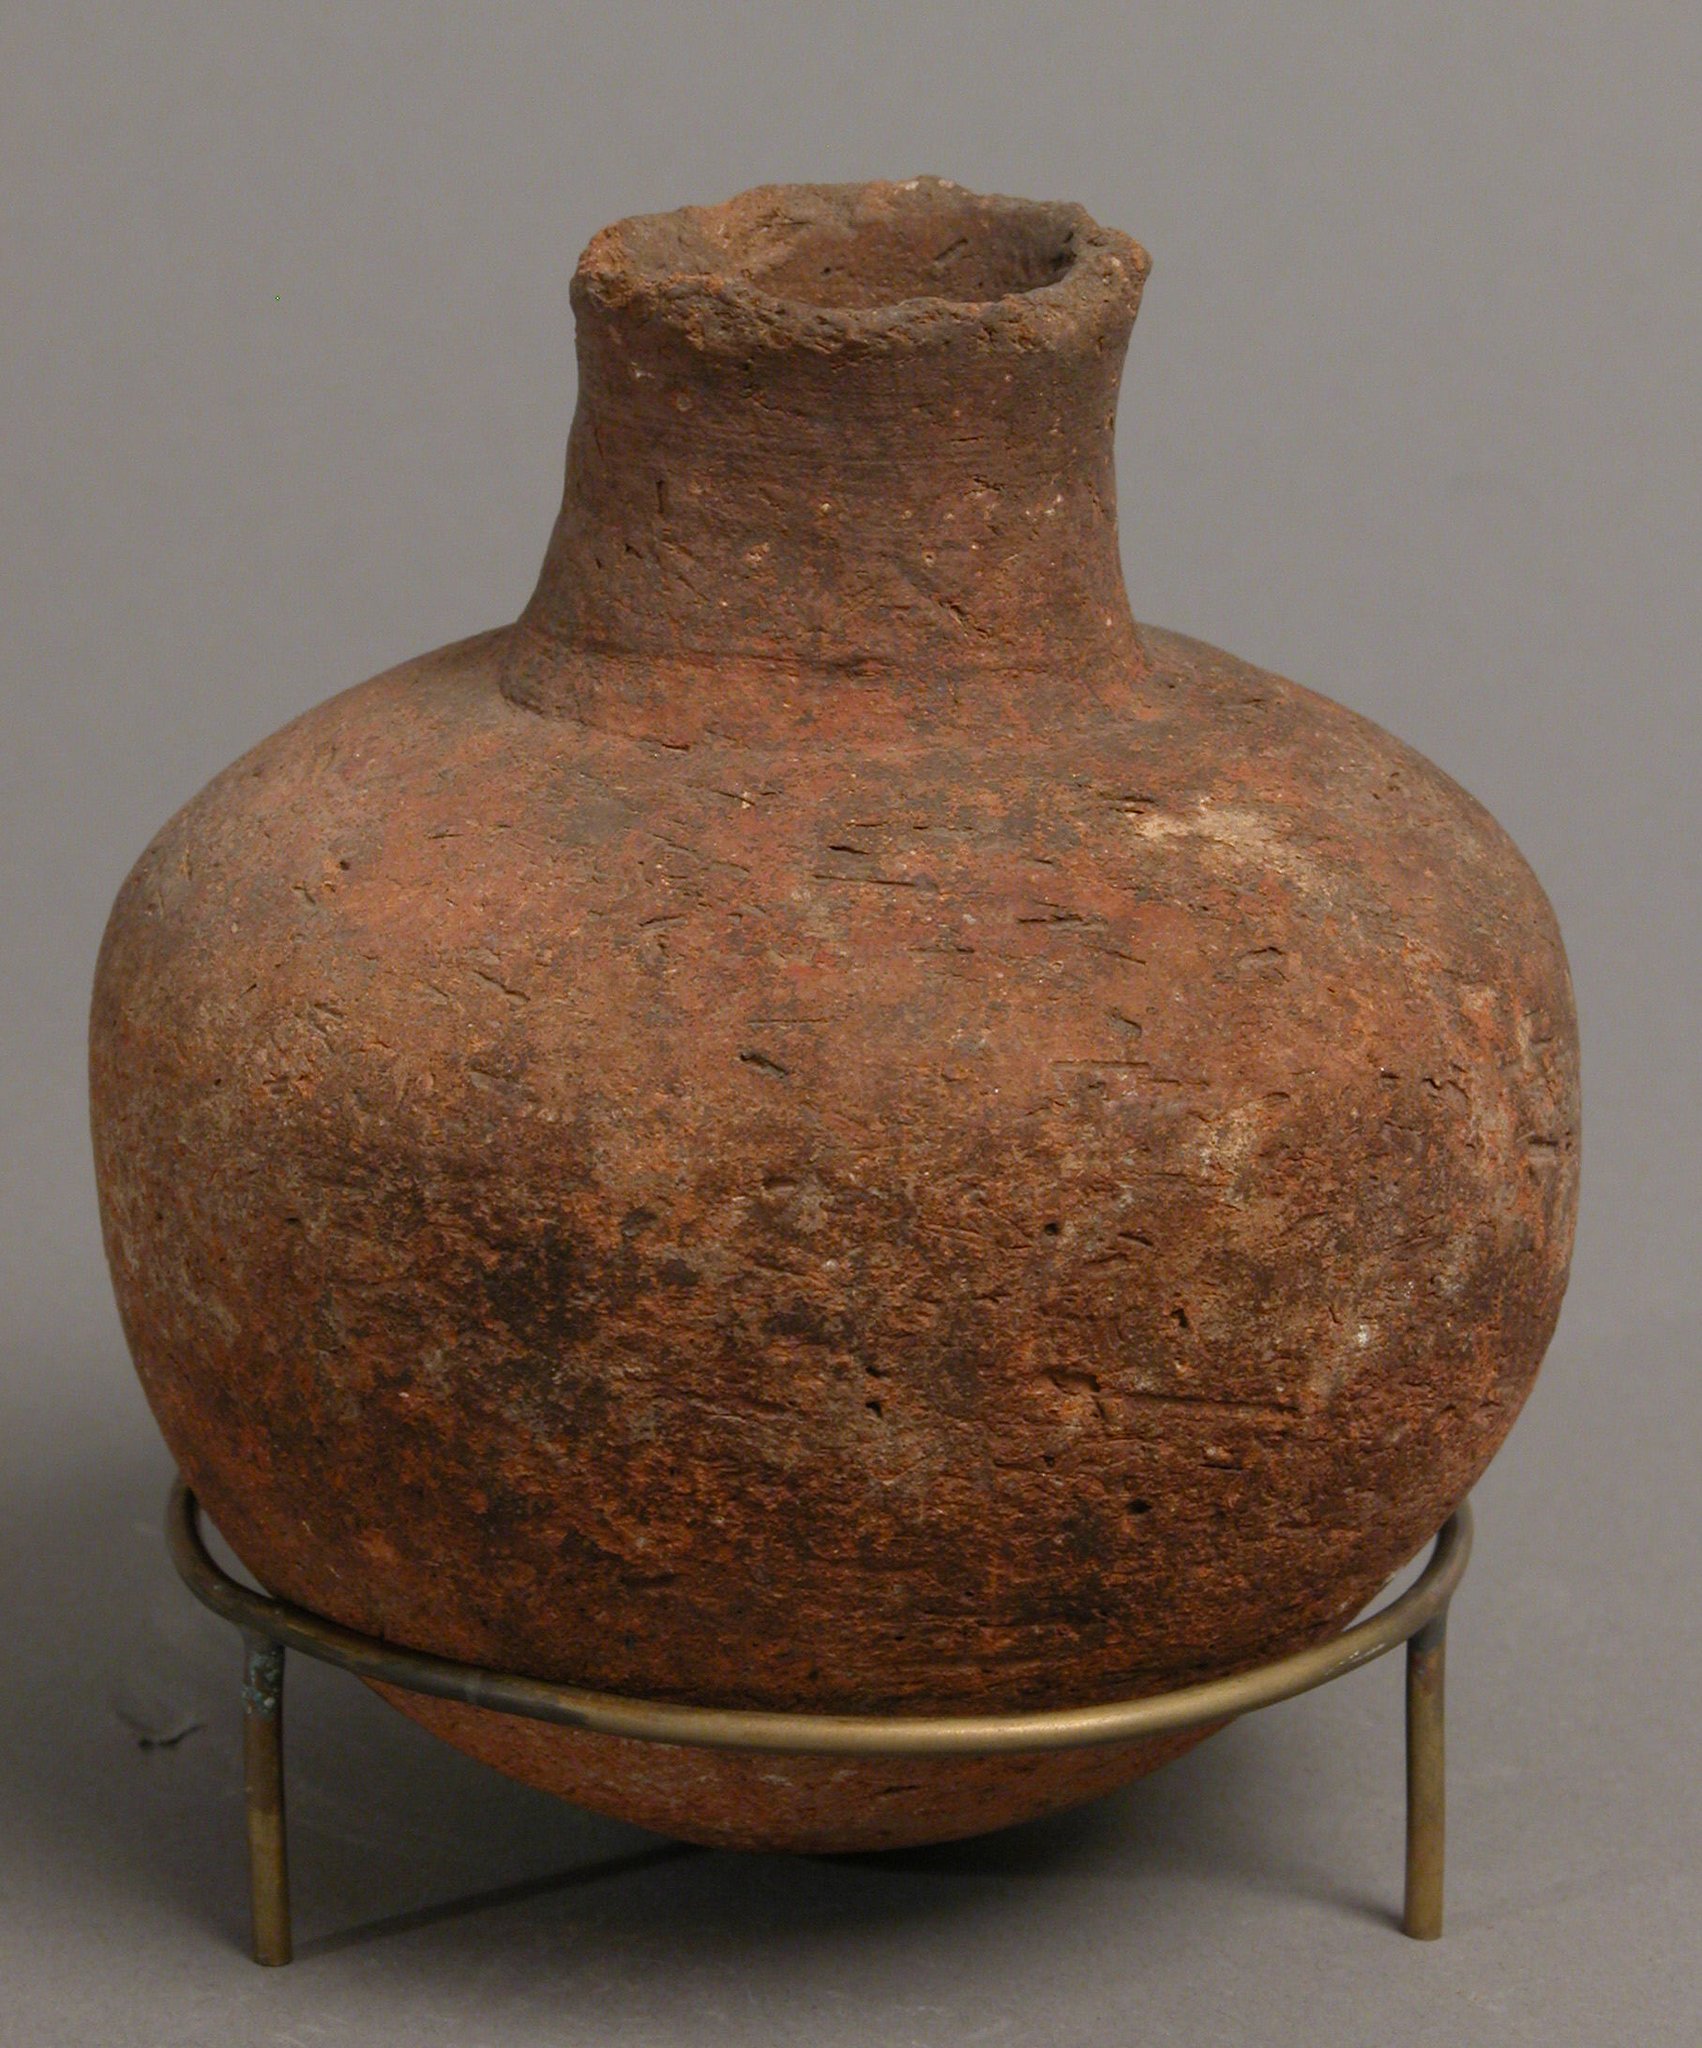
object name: pot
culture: coptic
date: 301-700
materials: earthenware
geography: egypt